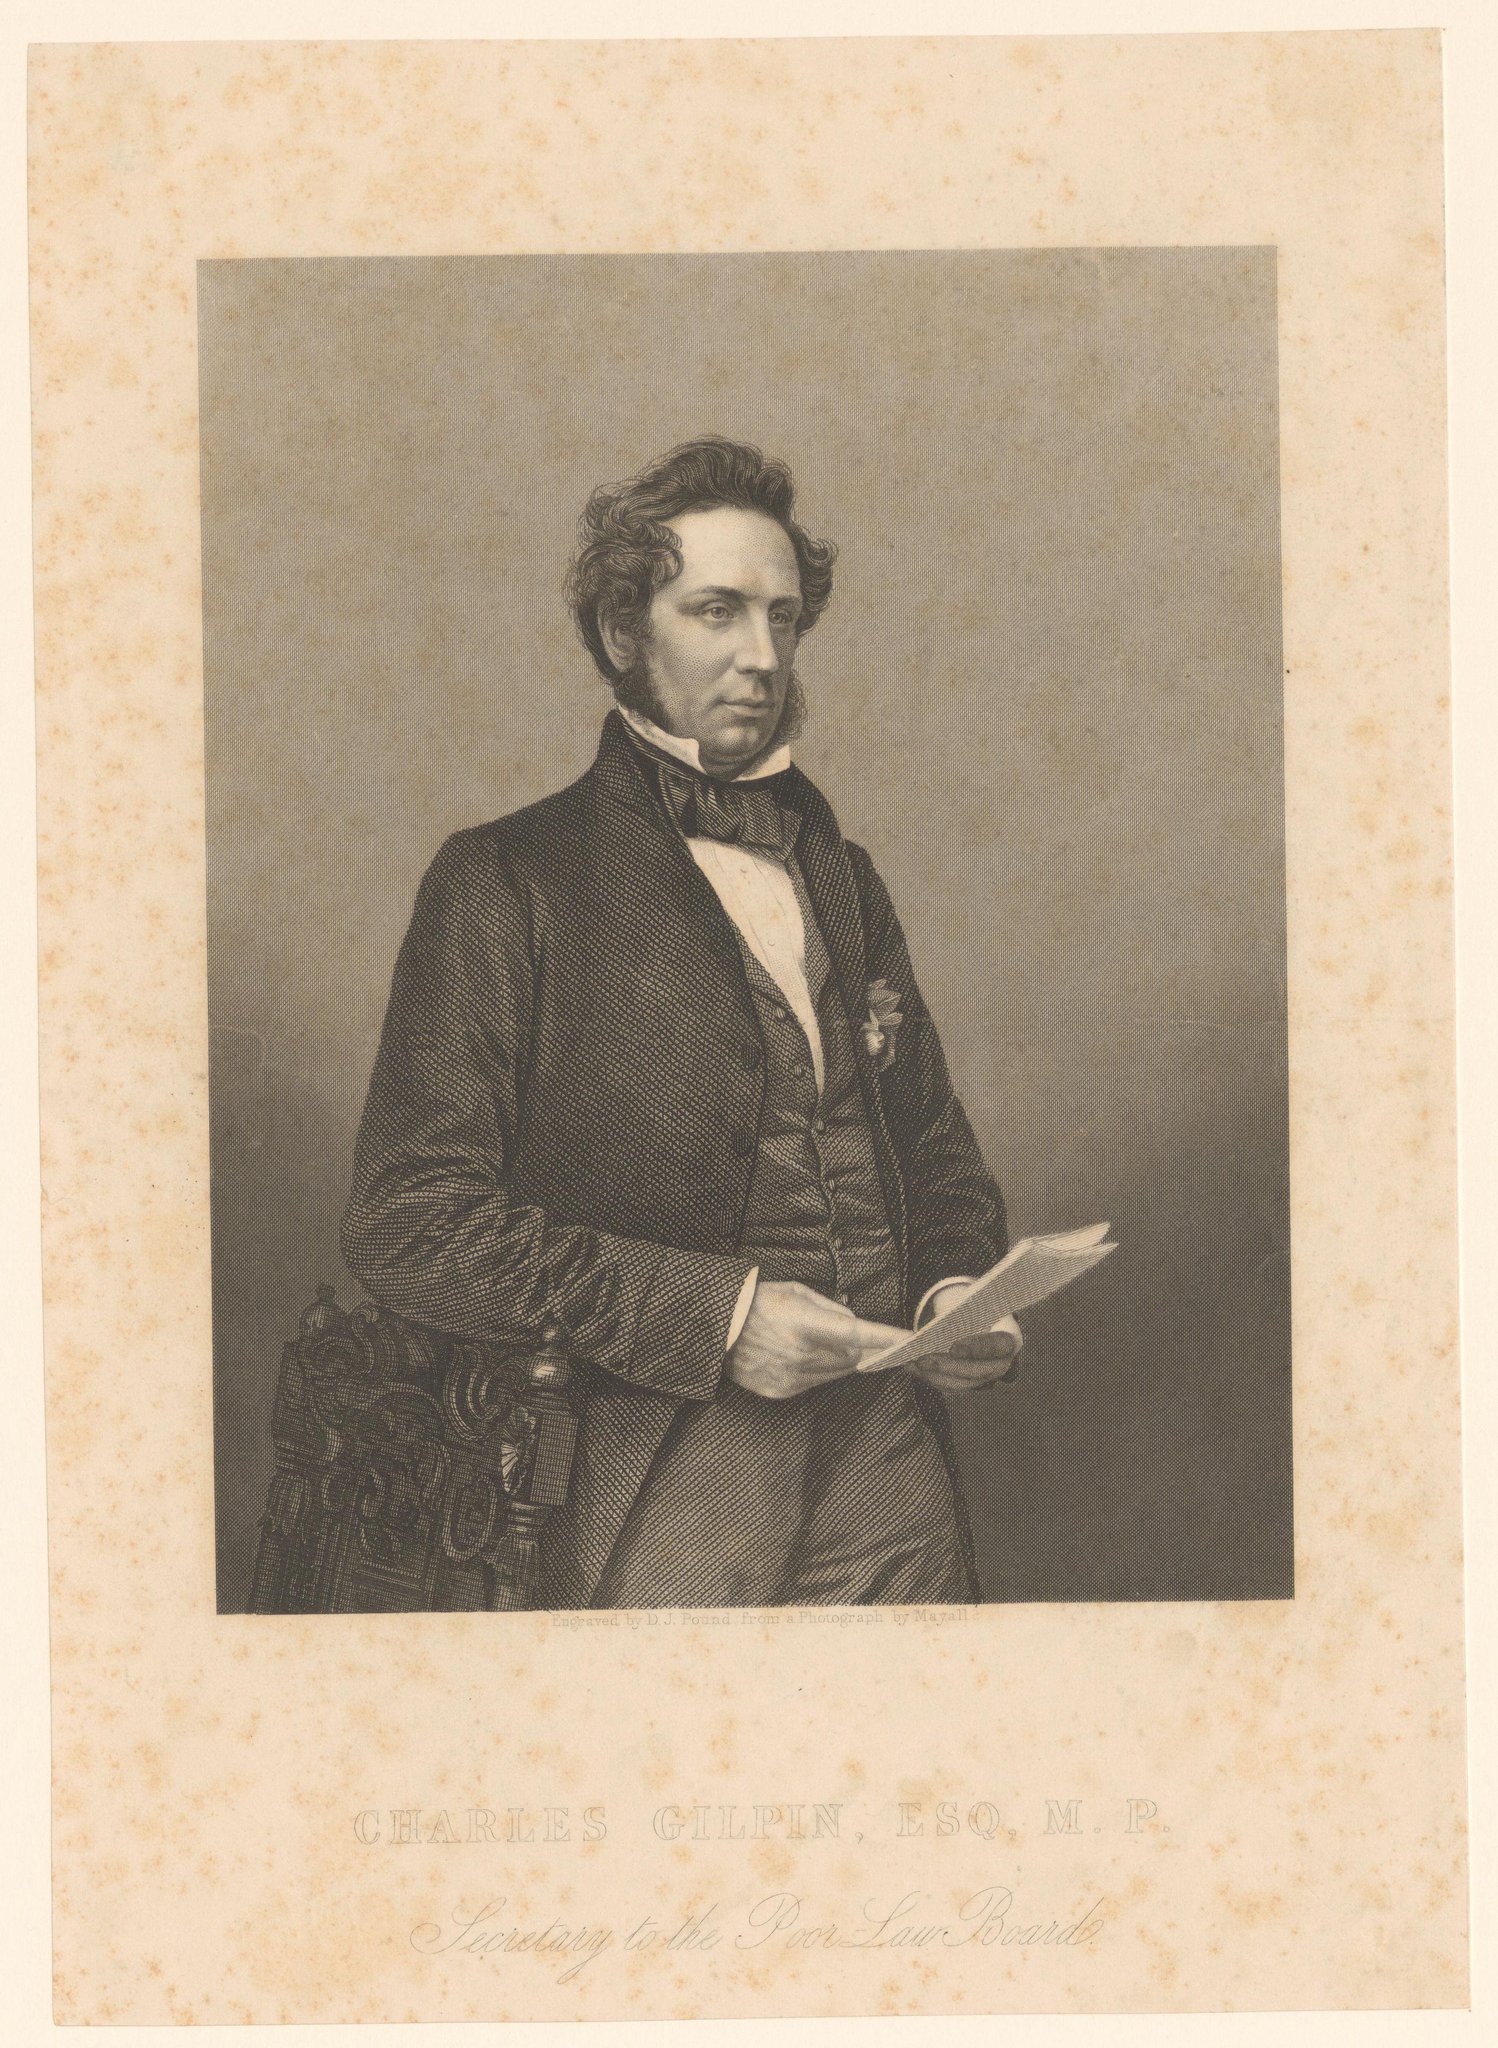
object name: print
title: Portret van Charles Gilpin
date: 1859-1862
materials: paper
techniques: engraving, etching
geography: london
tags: politician, historical persons, politician, e.g. party leader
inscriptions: collector's mark: Lugt 2228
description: Prent mogelijk uit: The drawing-room portrait gallery of eminent personages. Londen: London Joint Stock Newspaper Company, 1859-1862. Supplement bij Illustrated News of the World.